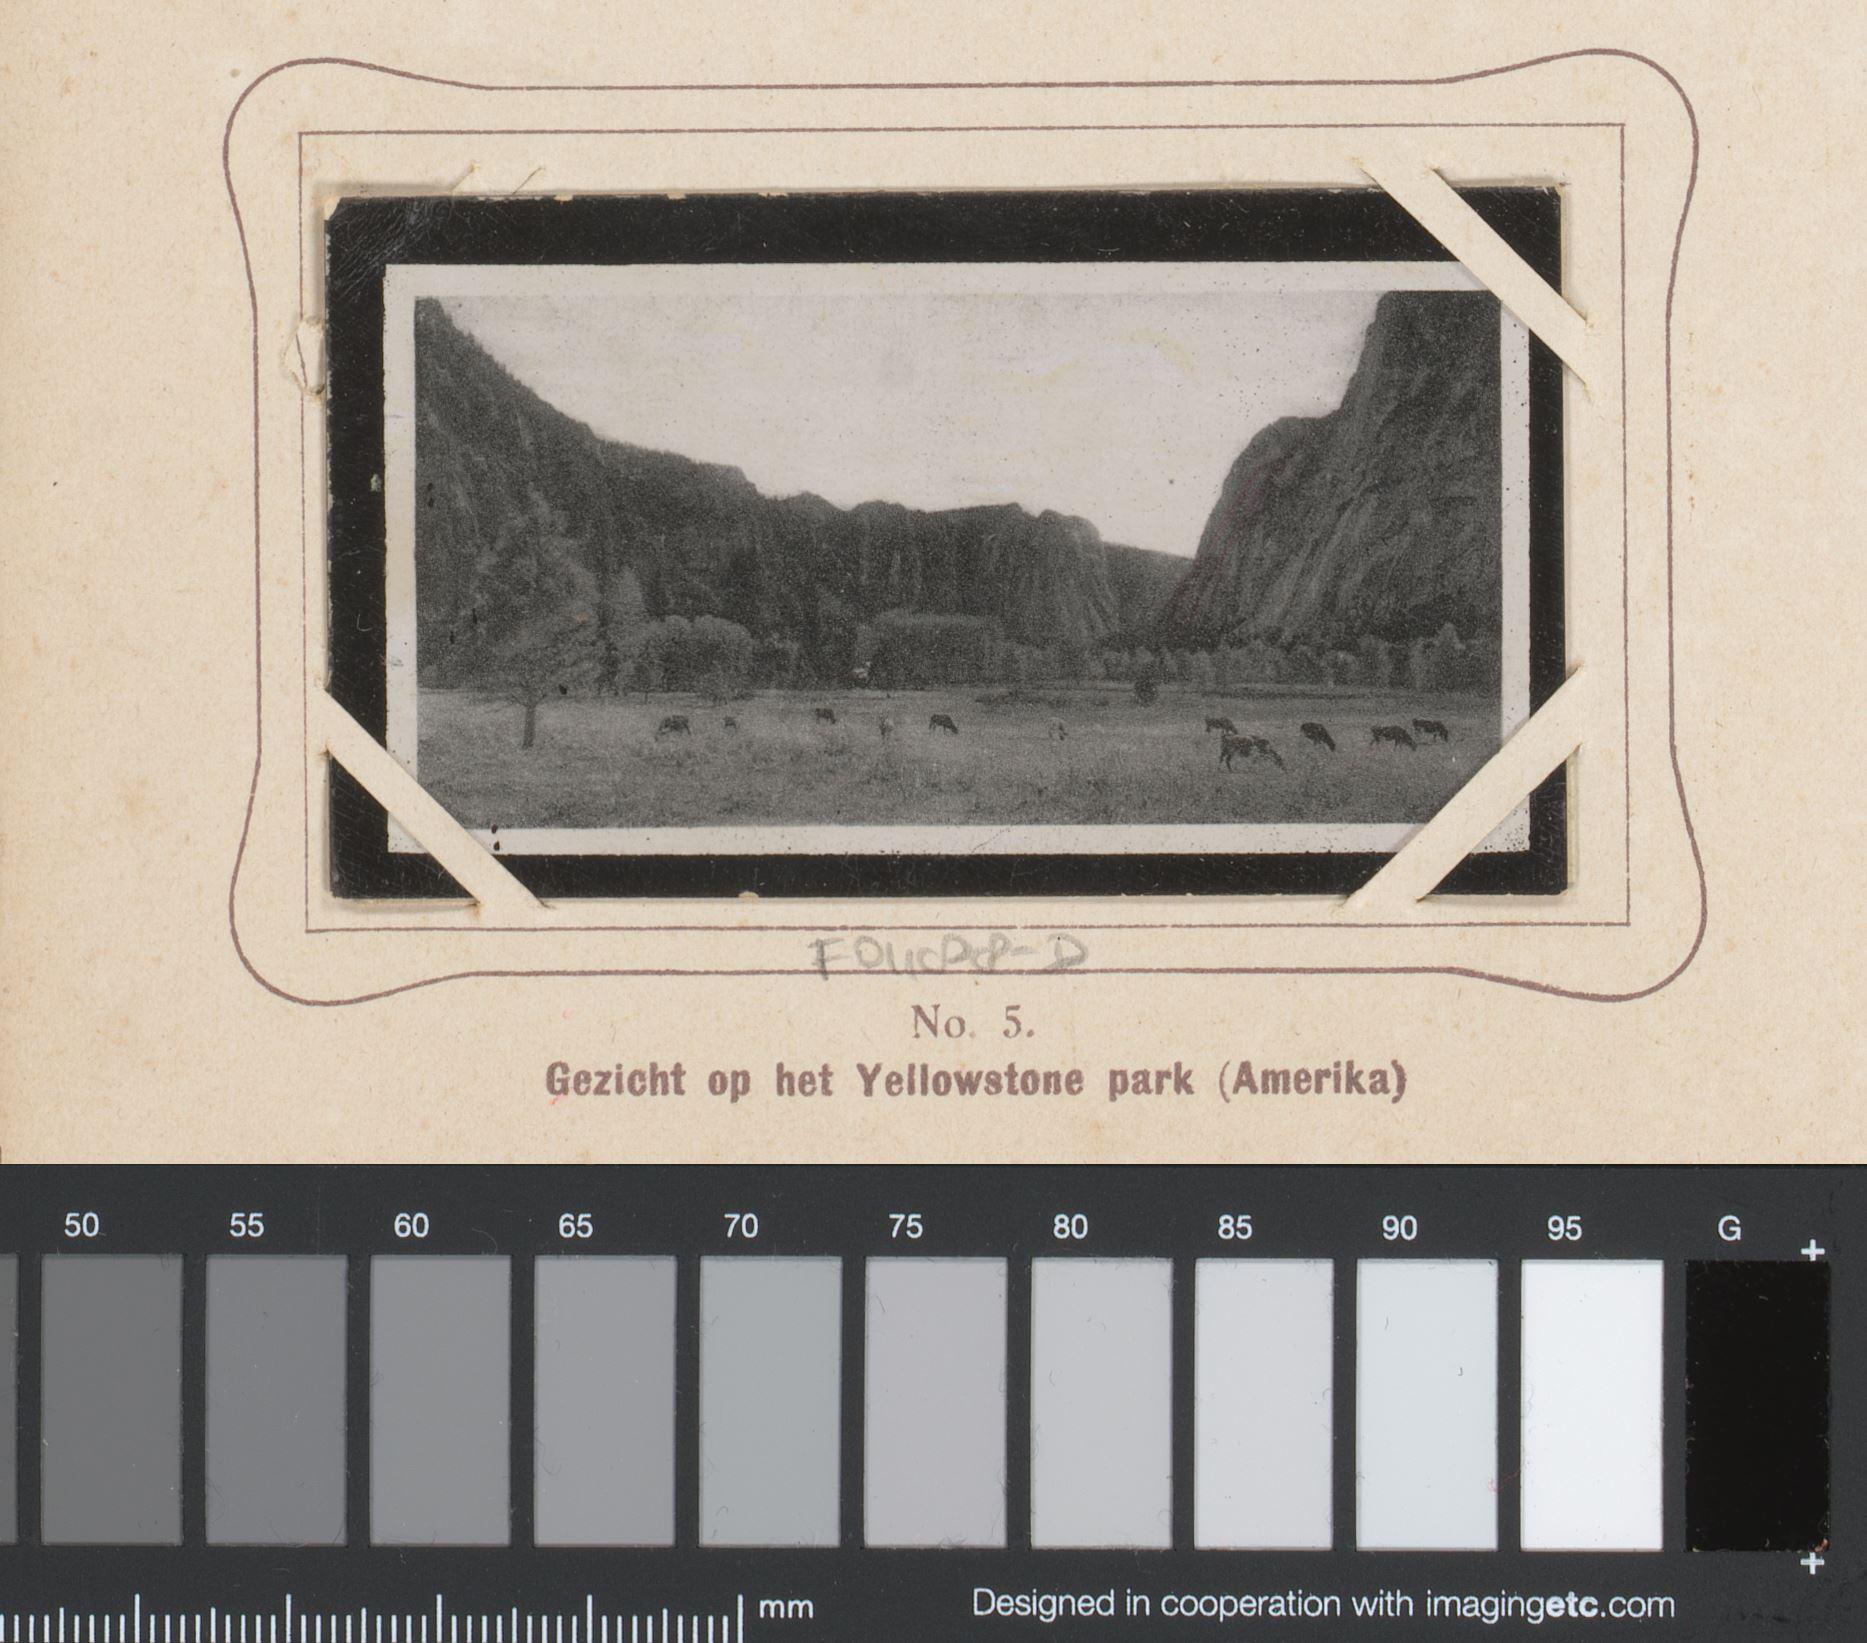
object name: album leaf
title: Landschap in het Yellowstone National Park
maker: Anonymous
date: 1906-1907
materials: paper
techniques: photograph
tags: wildlife reserve, national park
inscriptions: inscription: ‘No. 5./ Gezicht op het Yellowstone park (Amerika)’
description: Deze prent maakt deel uit van een album.